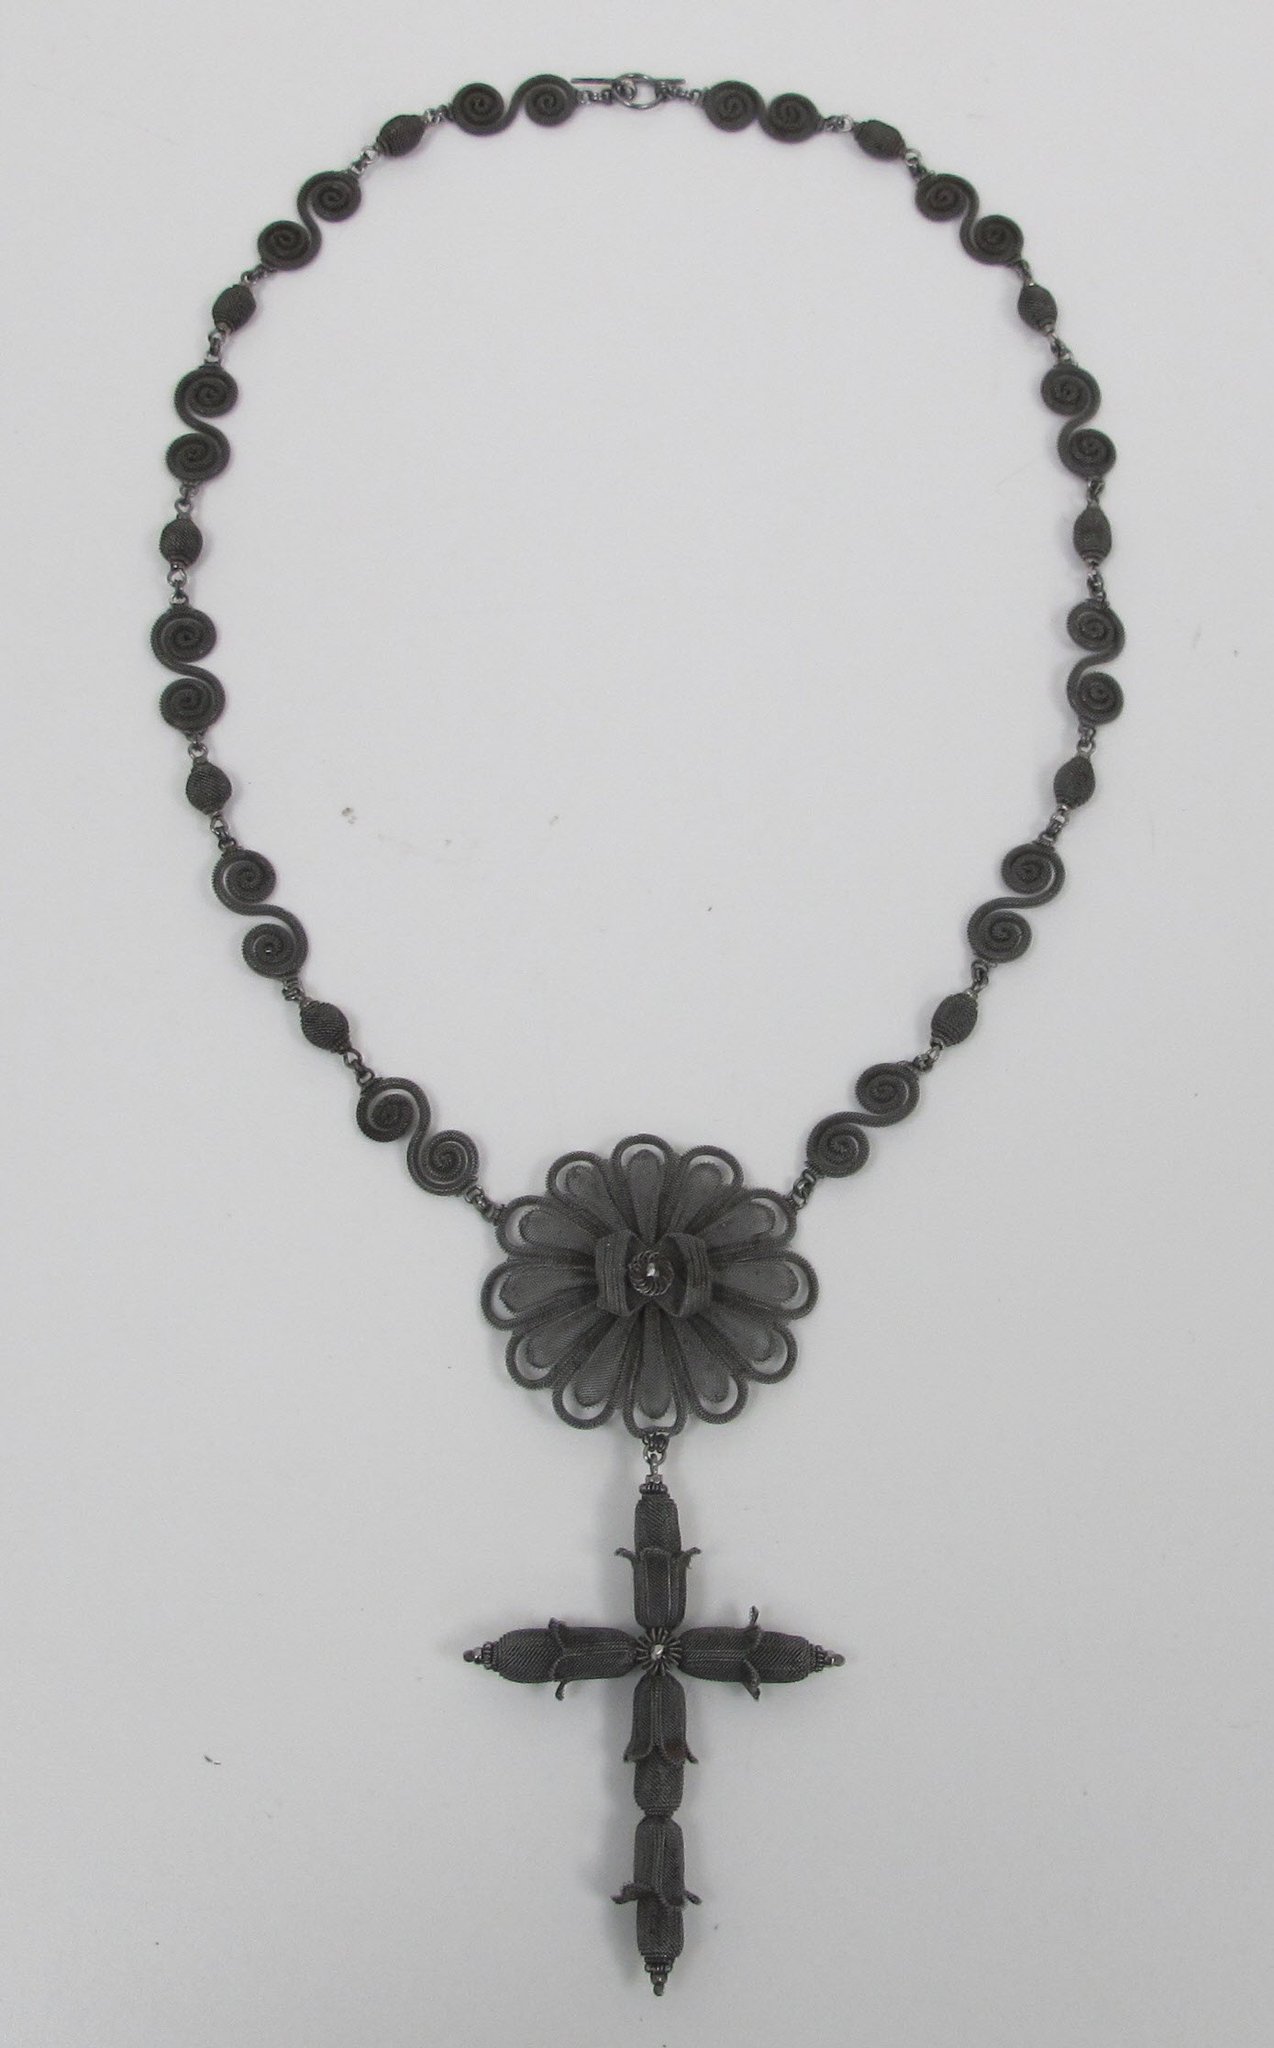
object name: necklace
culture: german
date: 1790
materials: iron